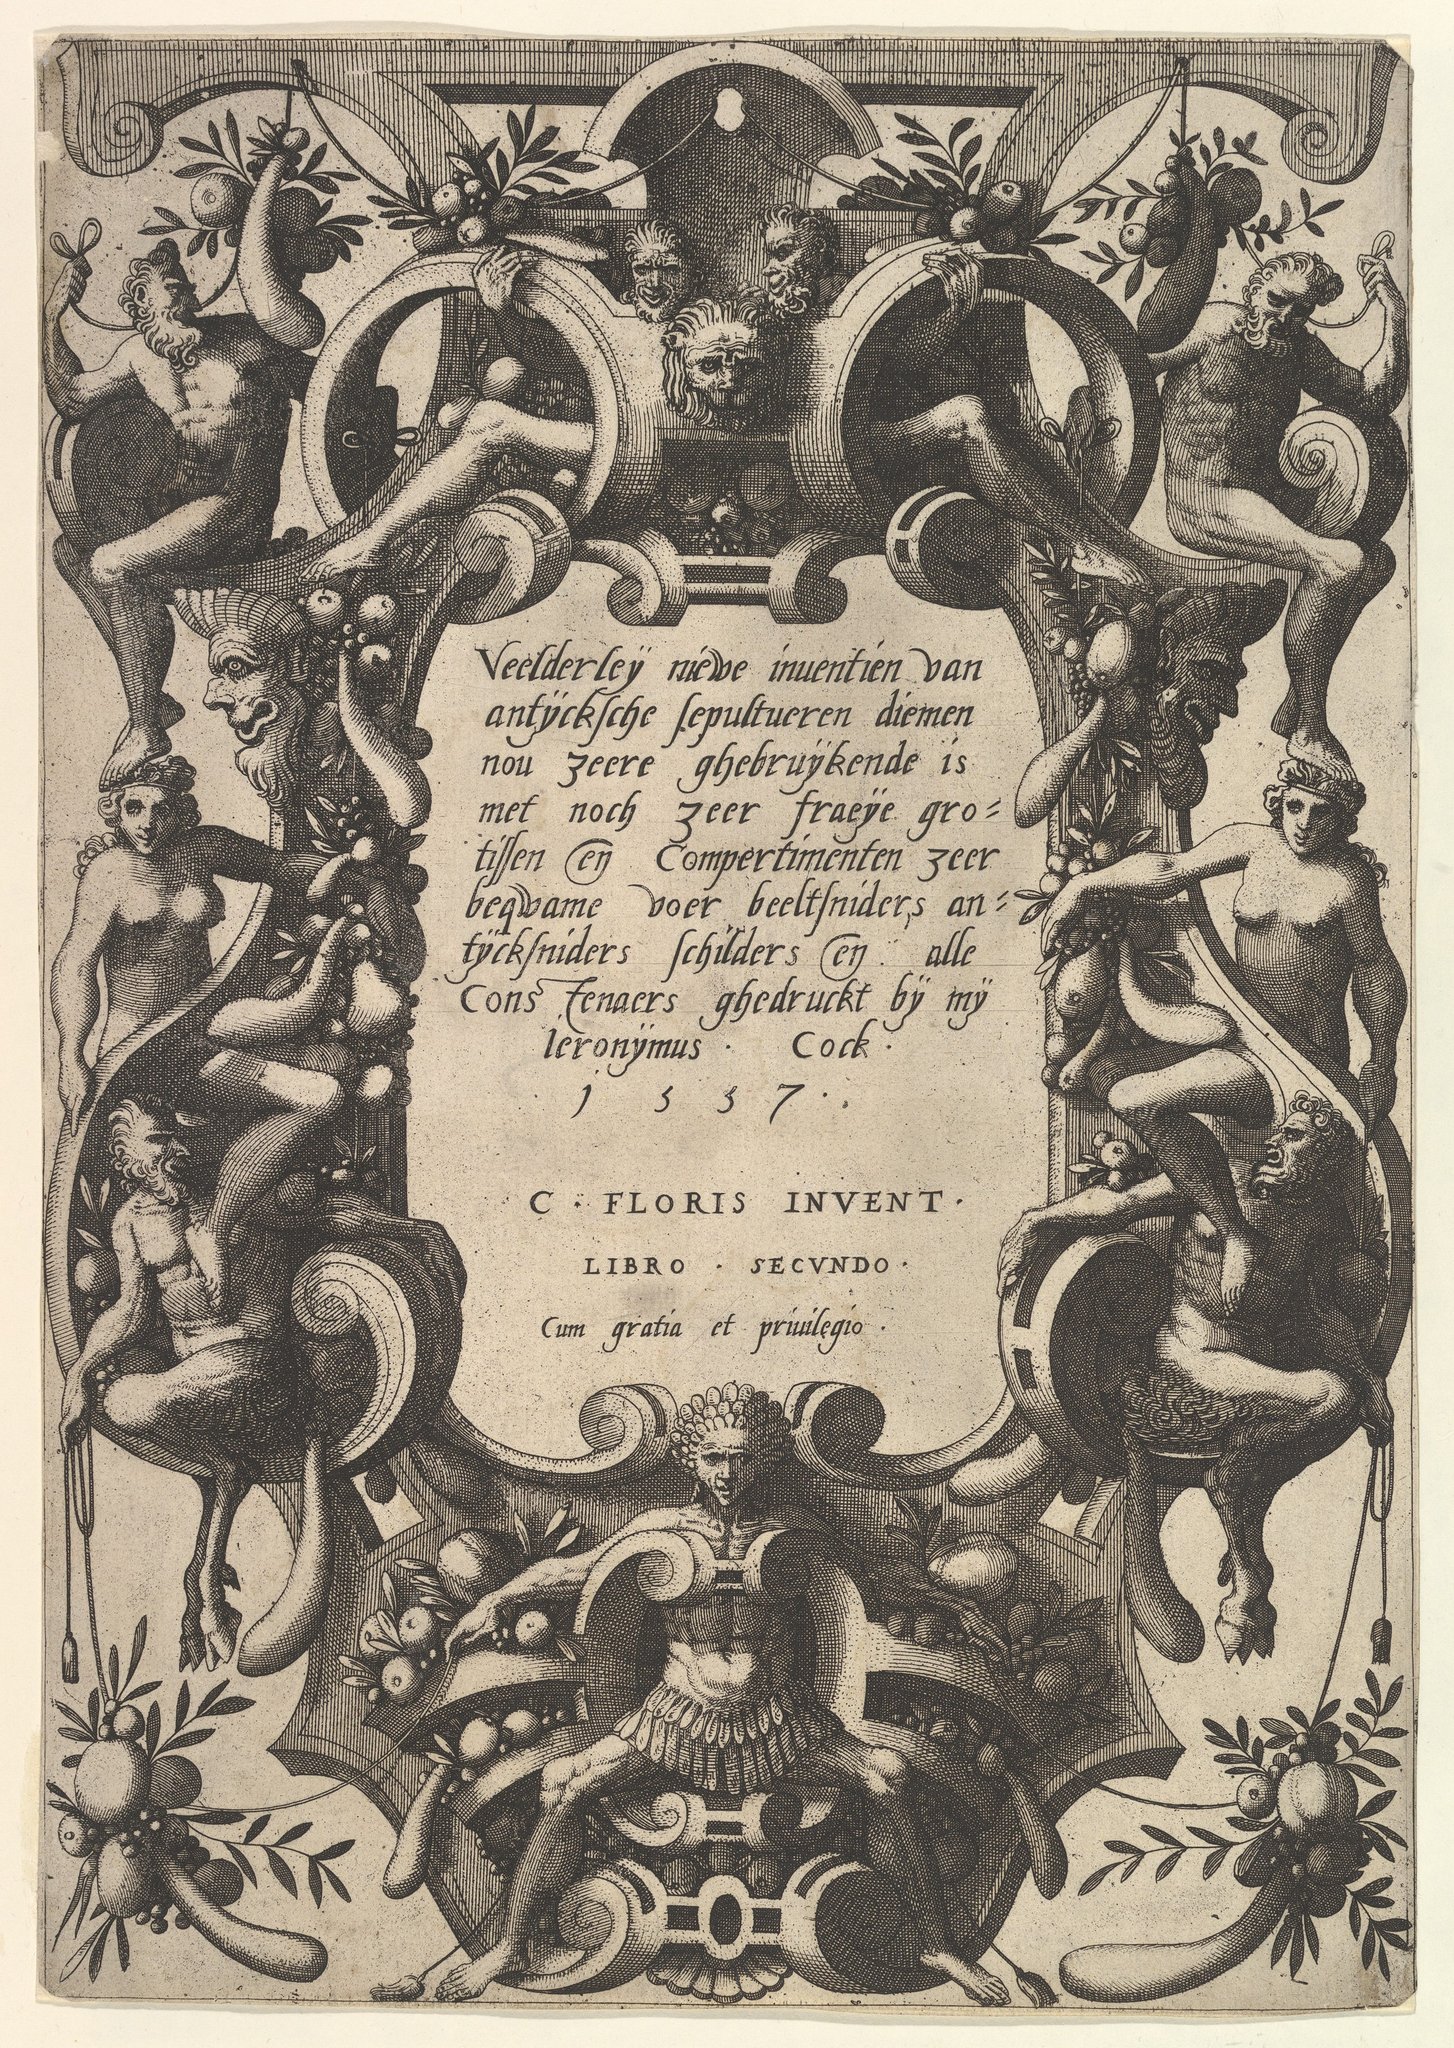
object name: book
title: Title Plate from Veelderleij niewe inventien van antijckesche sepultueren diemen nou zeere ghebruijkende is met noch zeer fraeije grotissen en compertimenten zeer beqwame voer beeltsniders antijcksniders schilders en all constenaers...Libro Secundo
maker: johannes van doetecum i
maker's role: artist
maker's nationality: netherlandish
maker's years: 1528-1605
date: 1557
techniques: etching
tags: male nudes,female nudes,lions